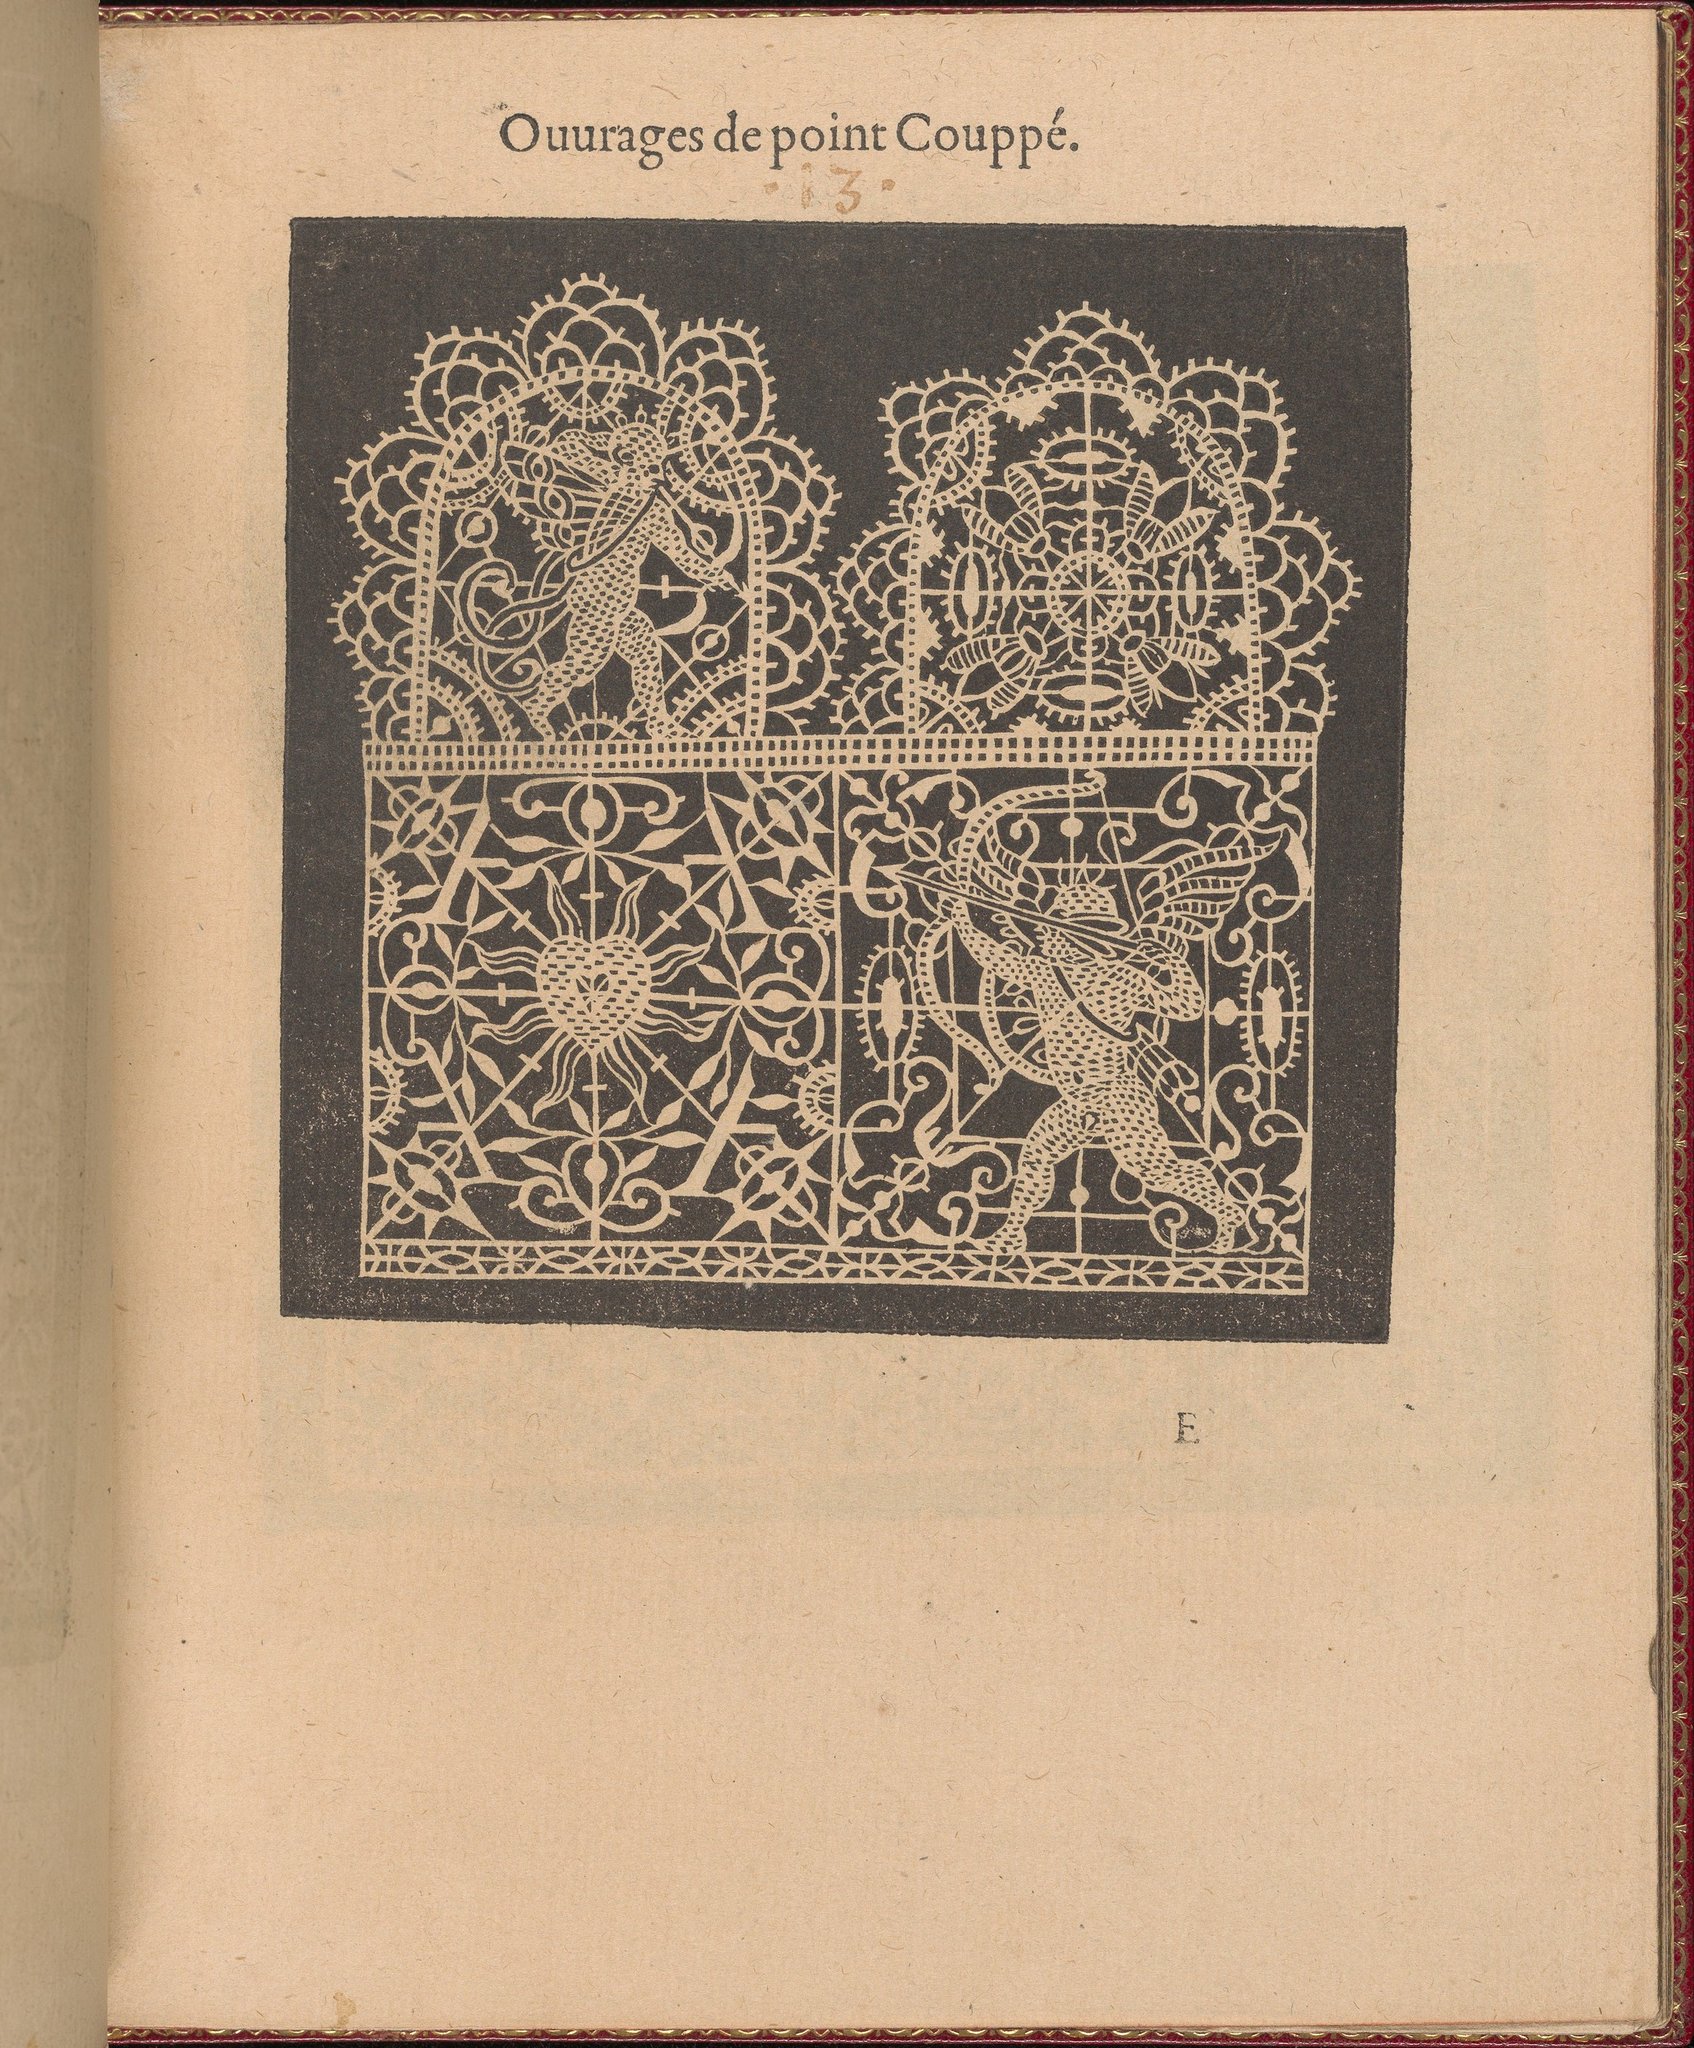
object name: book print ornament architecture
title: Les Singuliers et Nouveaux Portraicts... page 17 (recto)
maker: federico de vinciolo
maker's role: designer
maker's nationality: italian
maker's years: 1582-1599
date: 1588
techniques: woodcut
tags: bow and arrow,cupid,insects